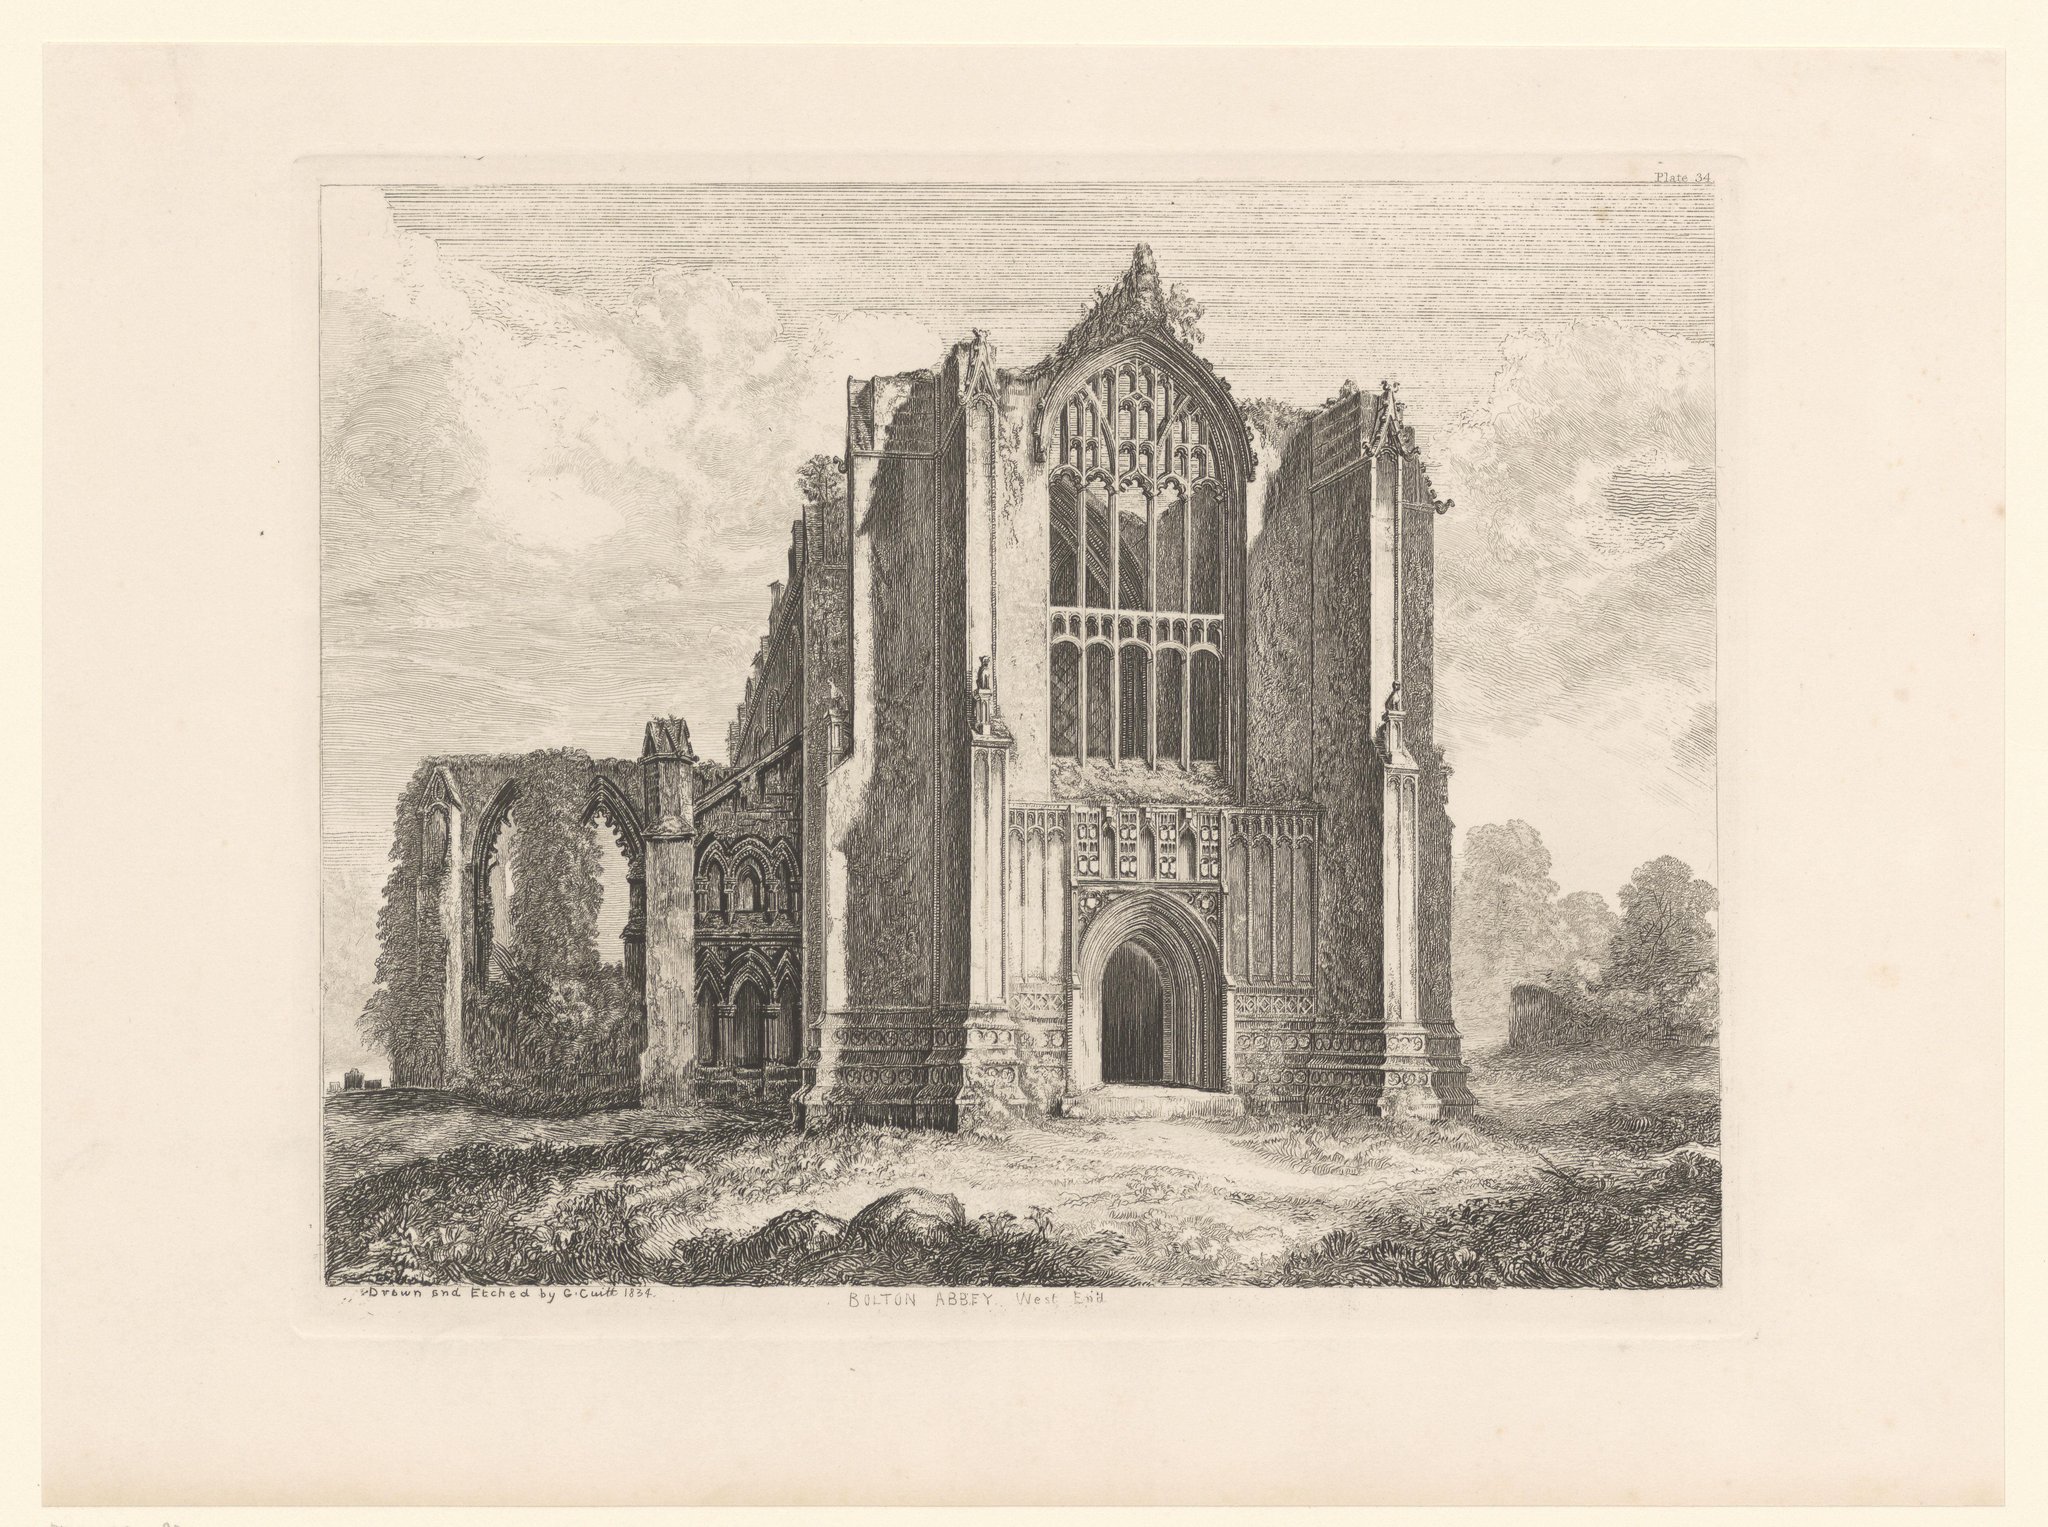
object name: print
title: Etsen van ruïnes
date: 1834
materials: paper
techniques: etching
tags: abbey, monastery, convent ~ roman catholic church, ruin of church, monastery, etc.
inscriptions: collector's mark: Lugt 2760, collector's mark: Lugt 2228